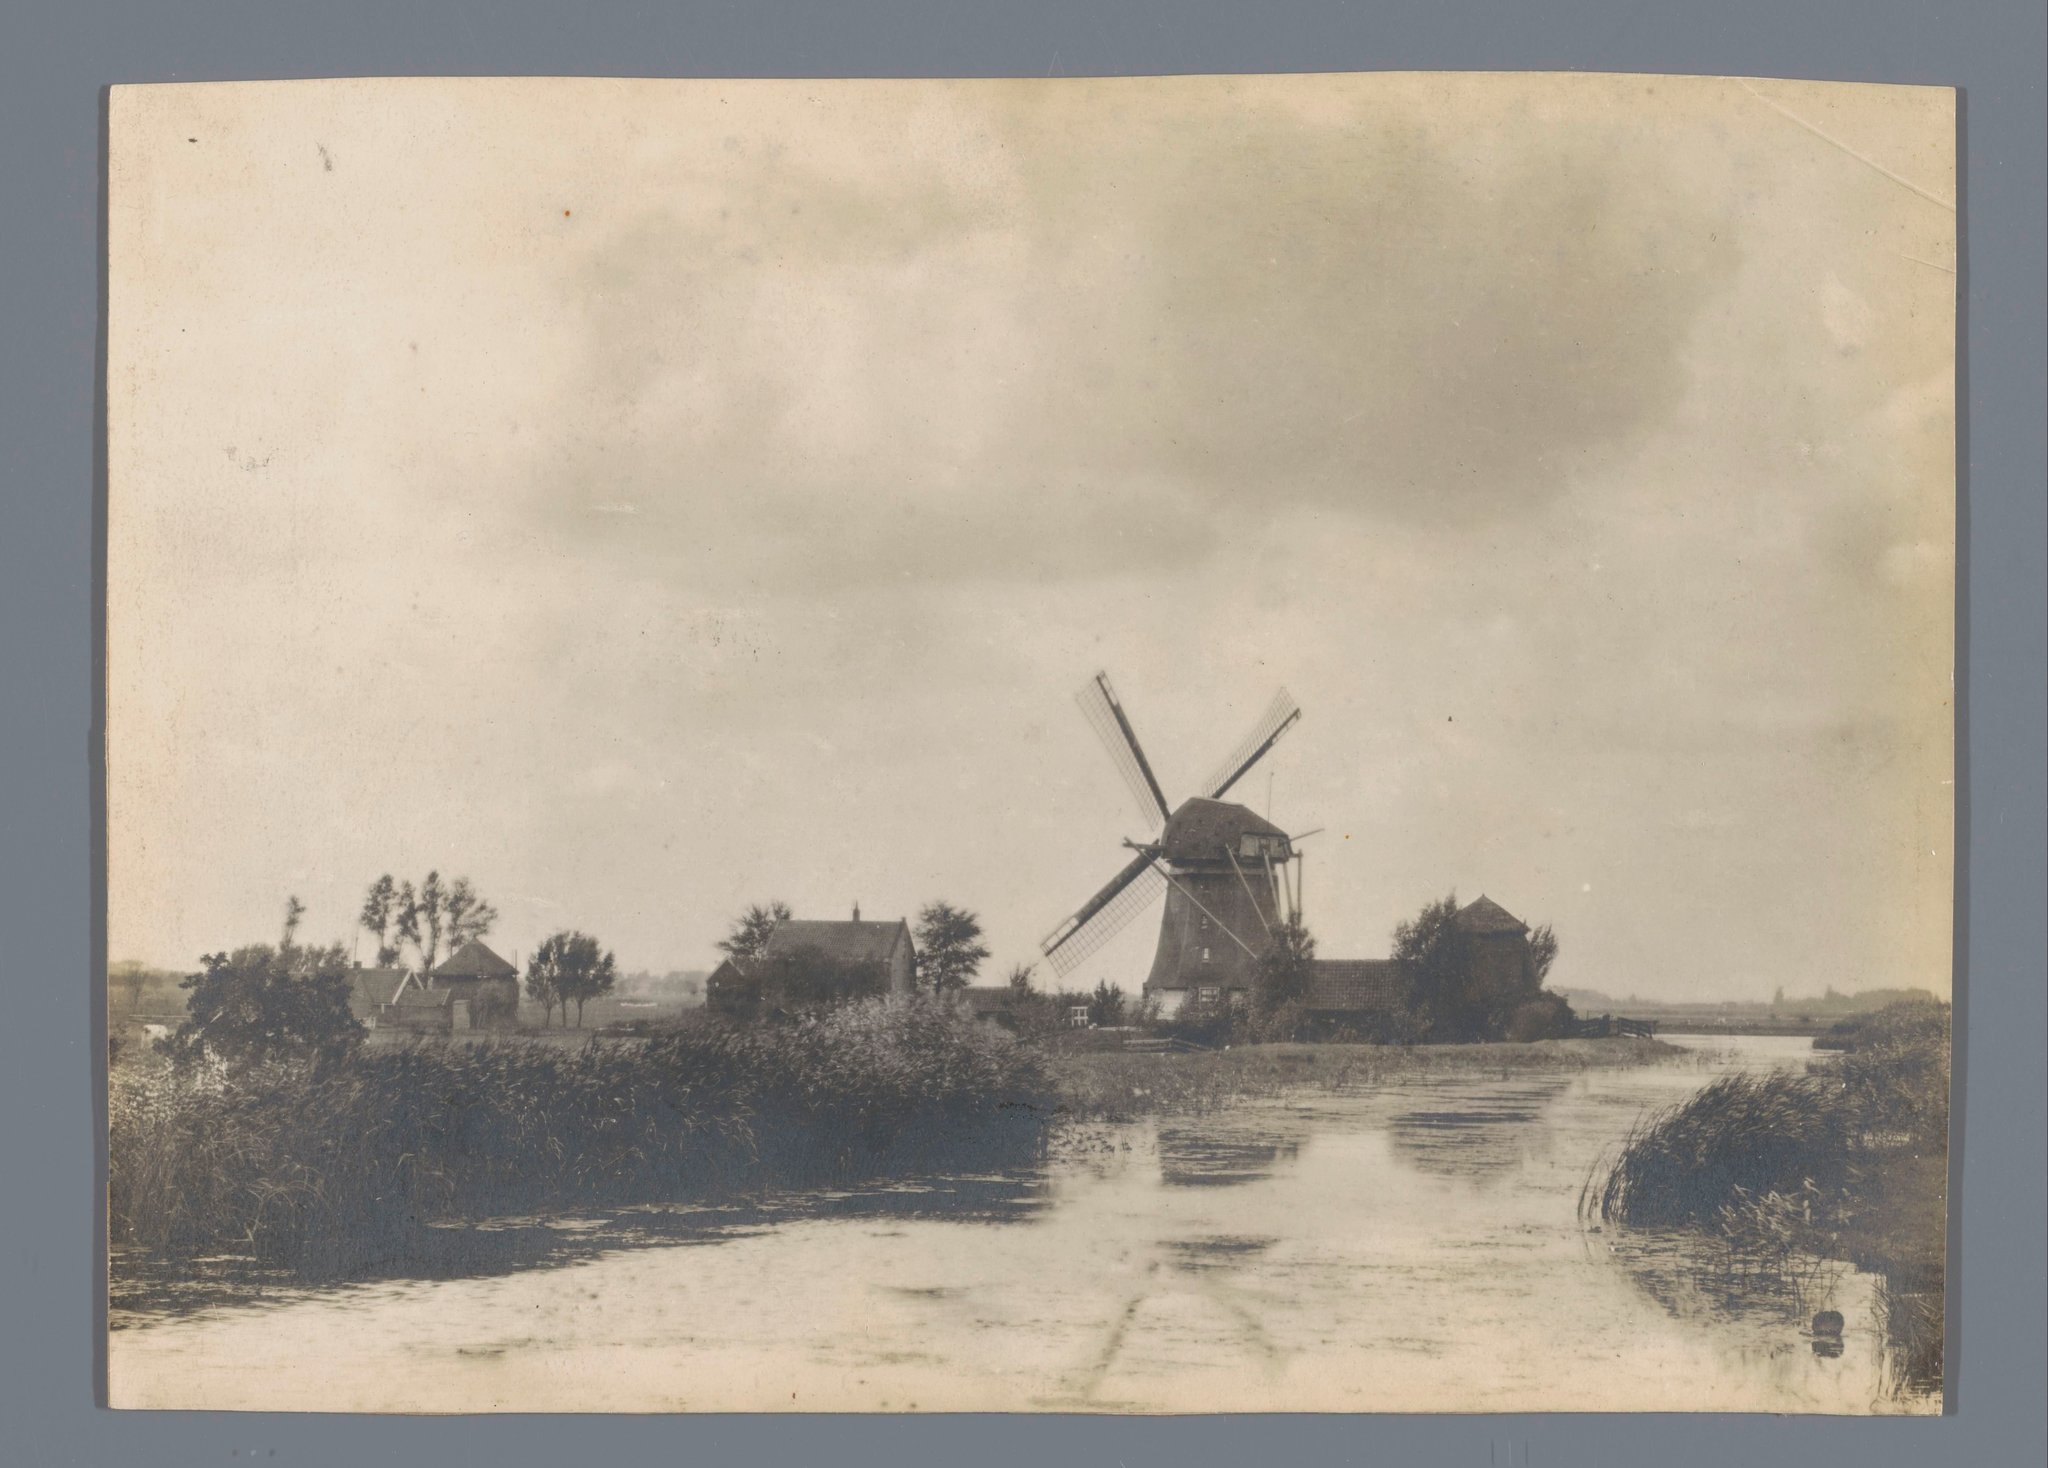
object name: photograph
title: Gezicht op een molen en boerderijen aan een rivier, Nederland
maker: alb. kapteijn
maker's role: amateurfotograaf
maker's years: 1848-1927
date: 1900-1925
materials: cardboard, paper, photographic support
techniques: gelatin silver print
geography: netherlands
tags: river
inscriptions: annotation: ‘1/2" 1/4d / 11/2" 1/4d’